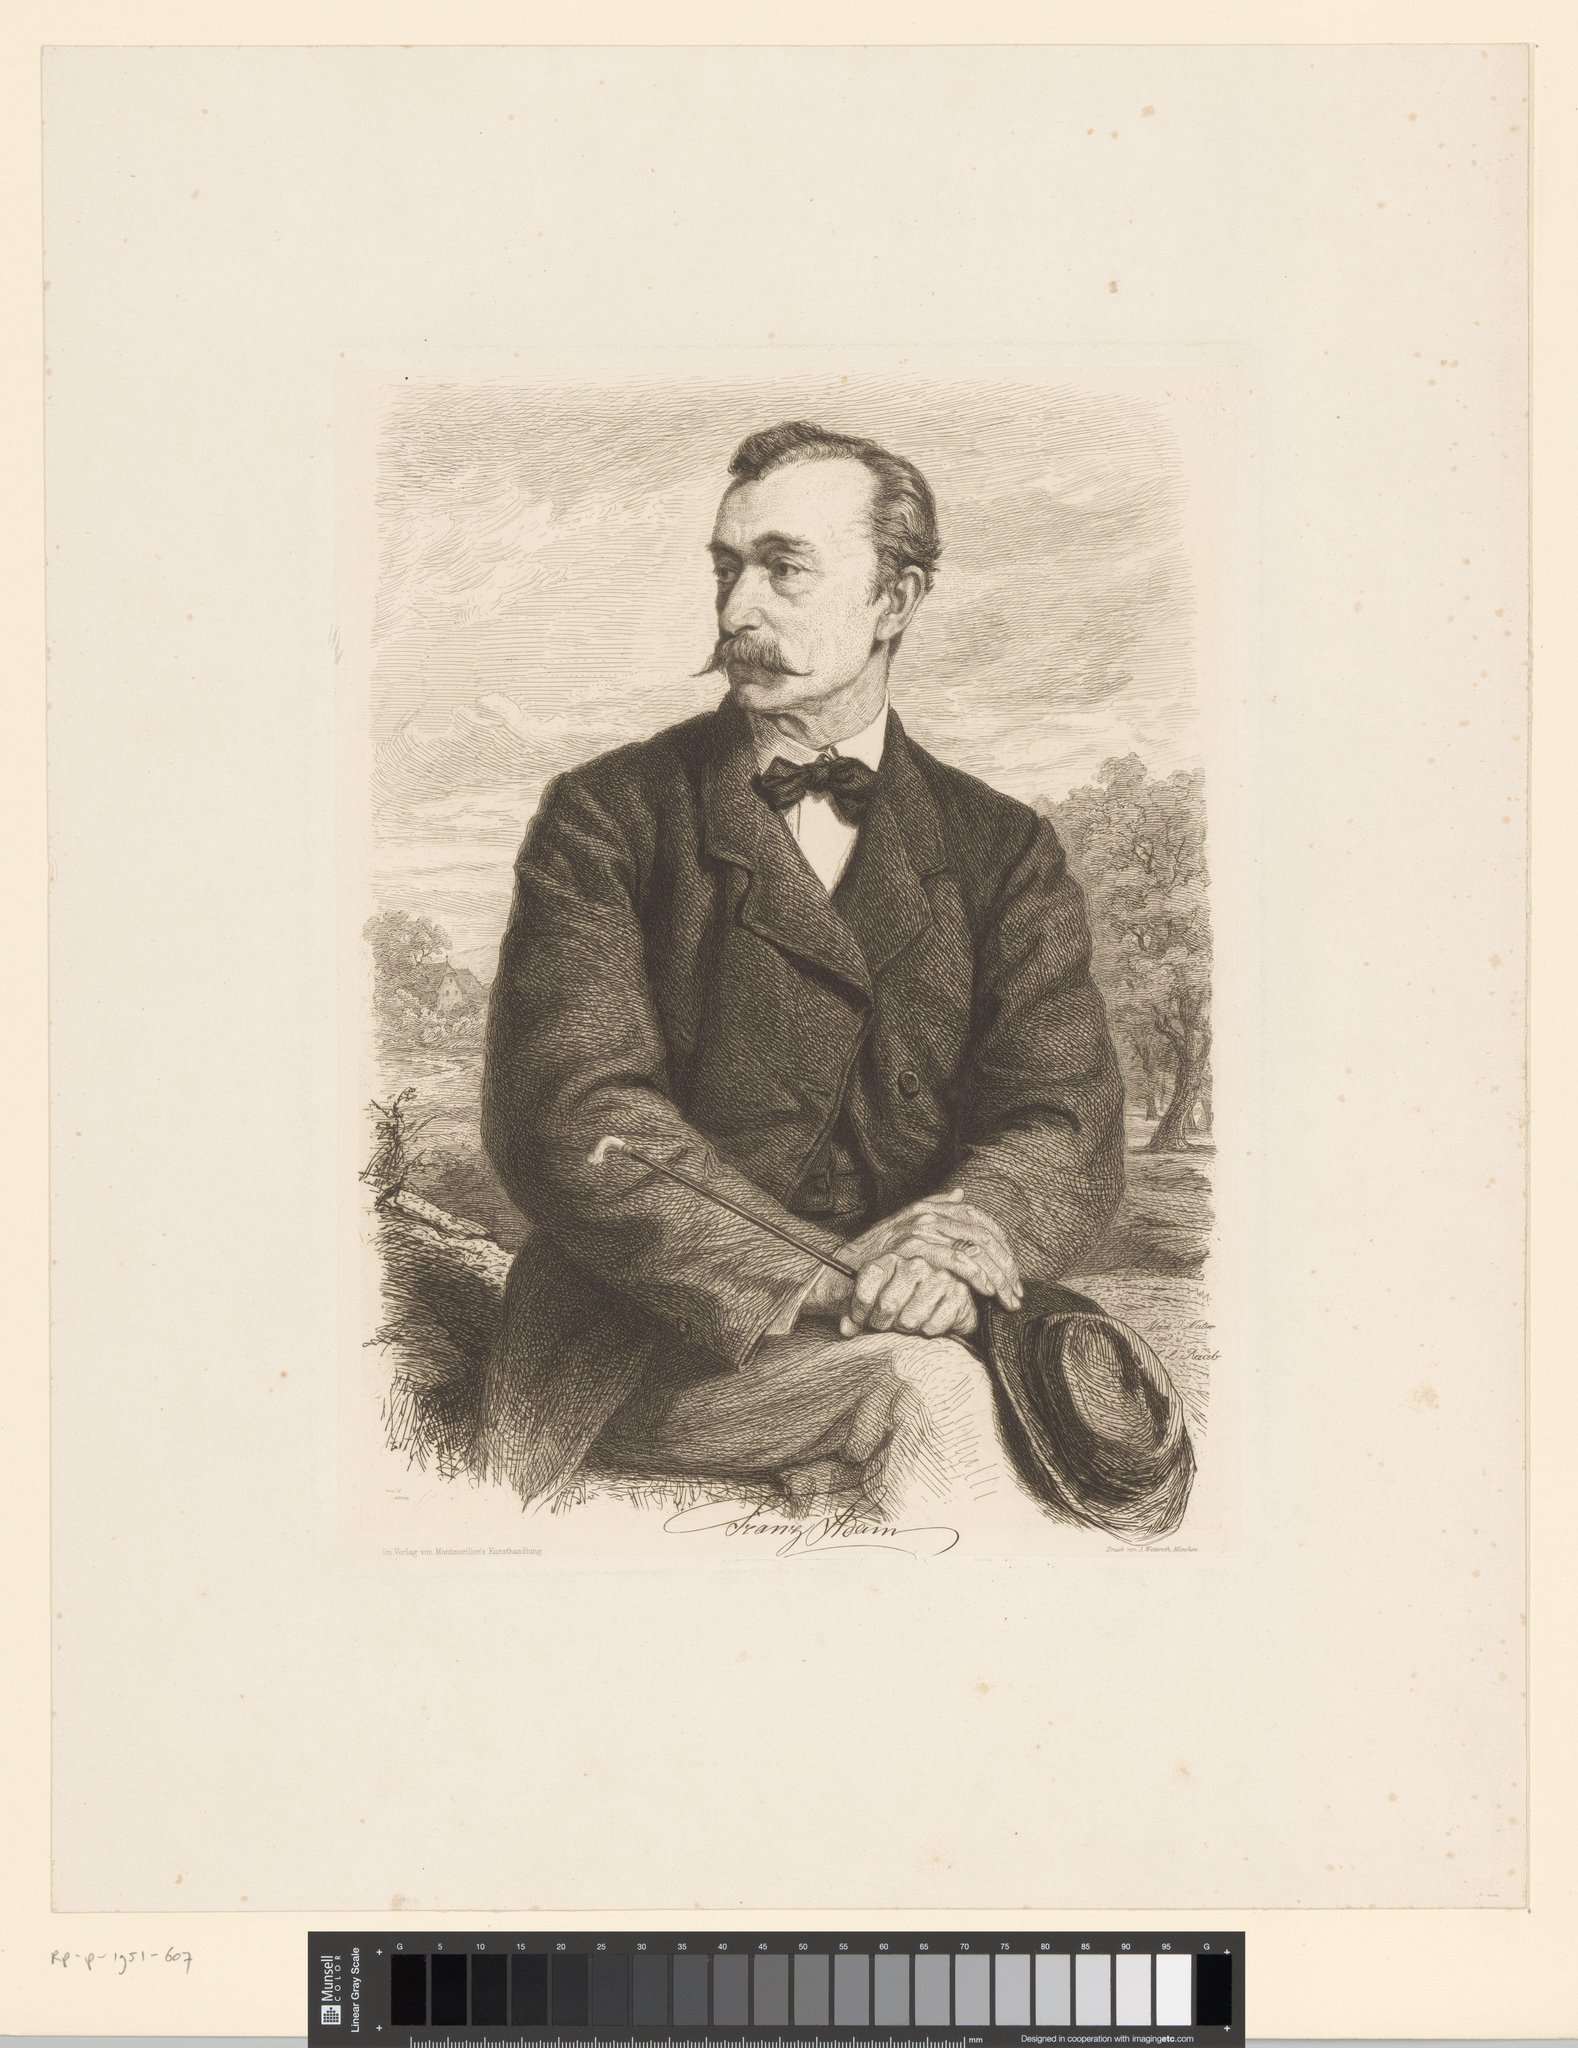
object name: print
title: Portret van Franz Adam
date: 1840-1899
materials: paper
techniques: etching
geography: munich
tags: print maker, franz adam, city-view, and landscape with man-made constructions, walking-stick, staff, portrait, self-portrait of graphic artist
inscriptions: collector's mark: Lugt 2228